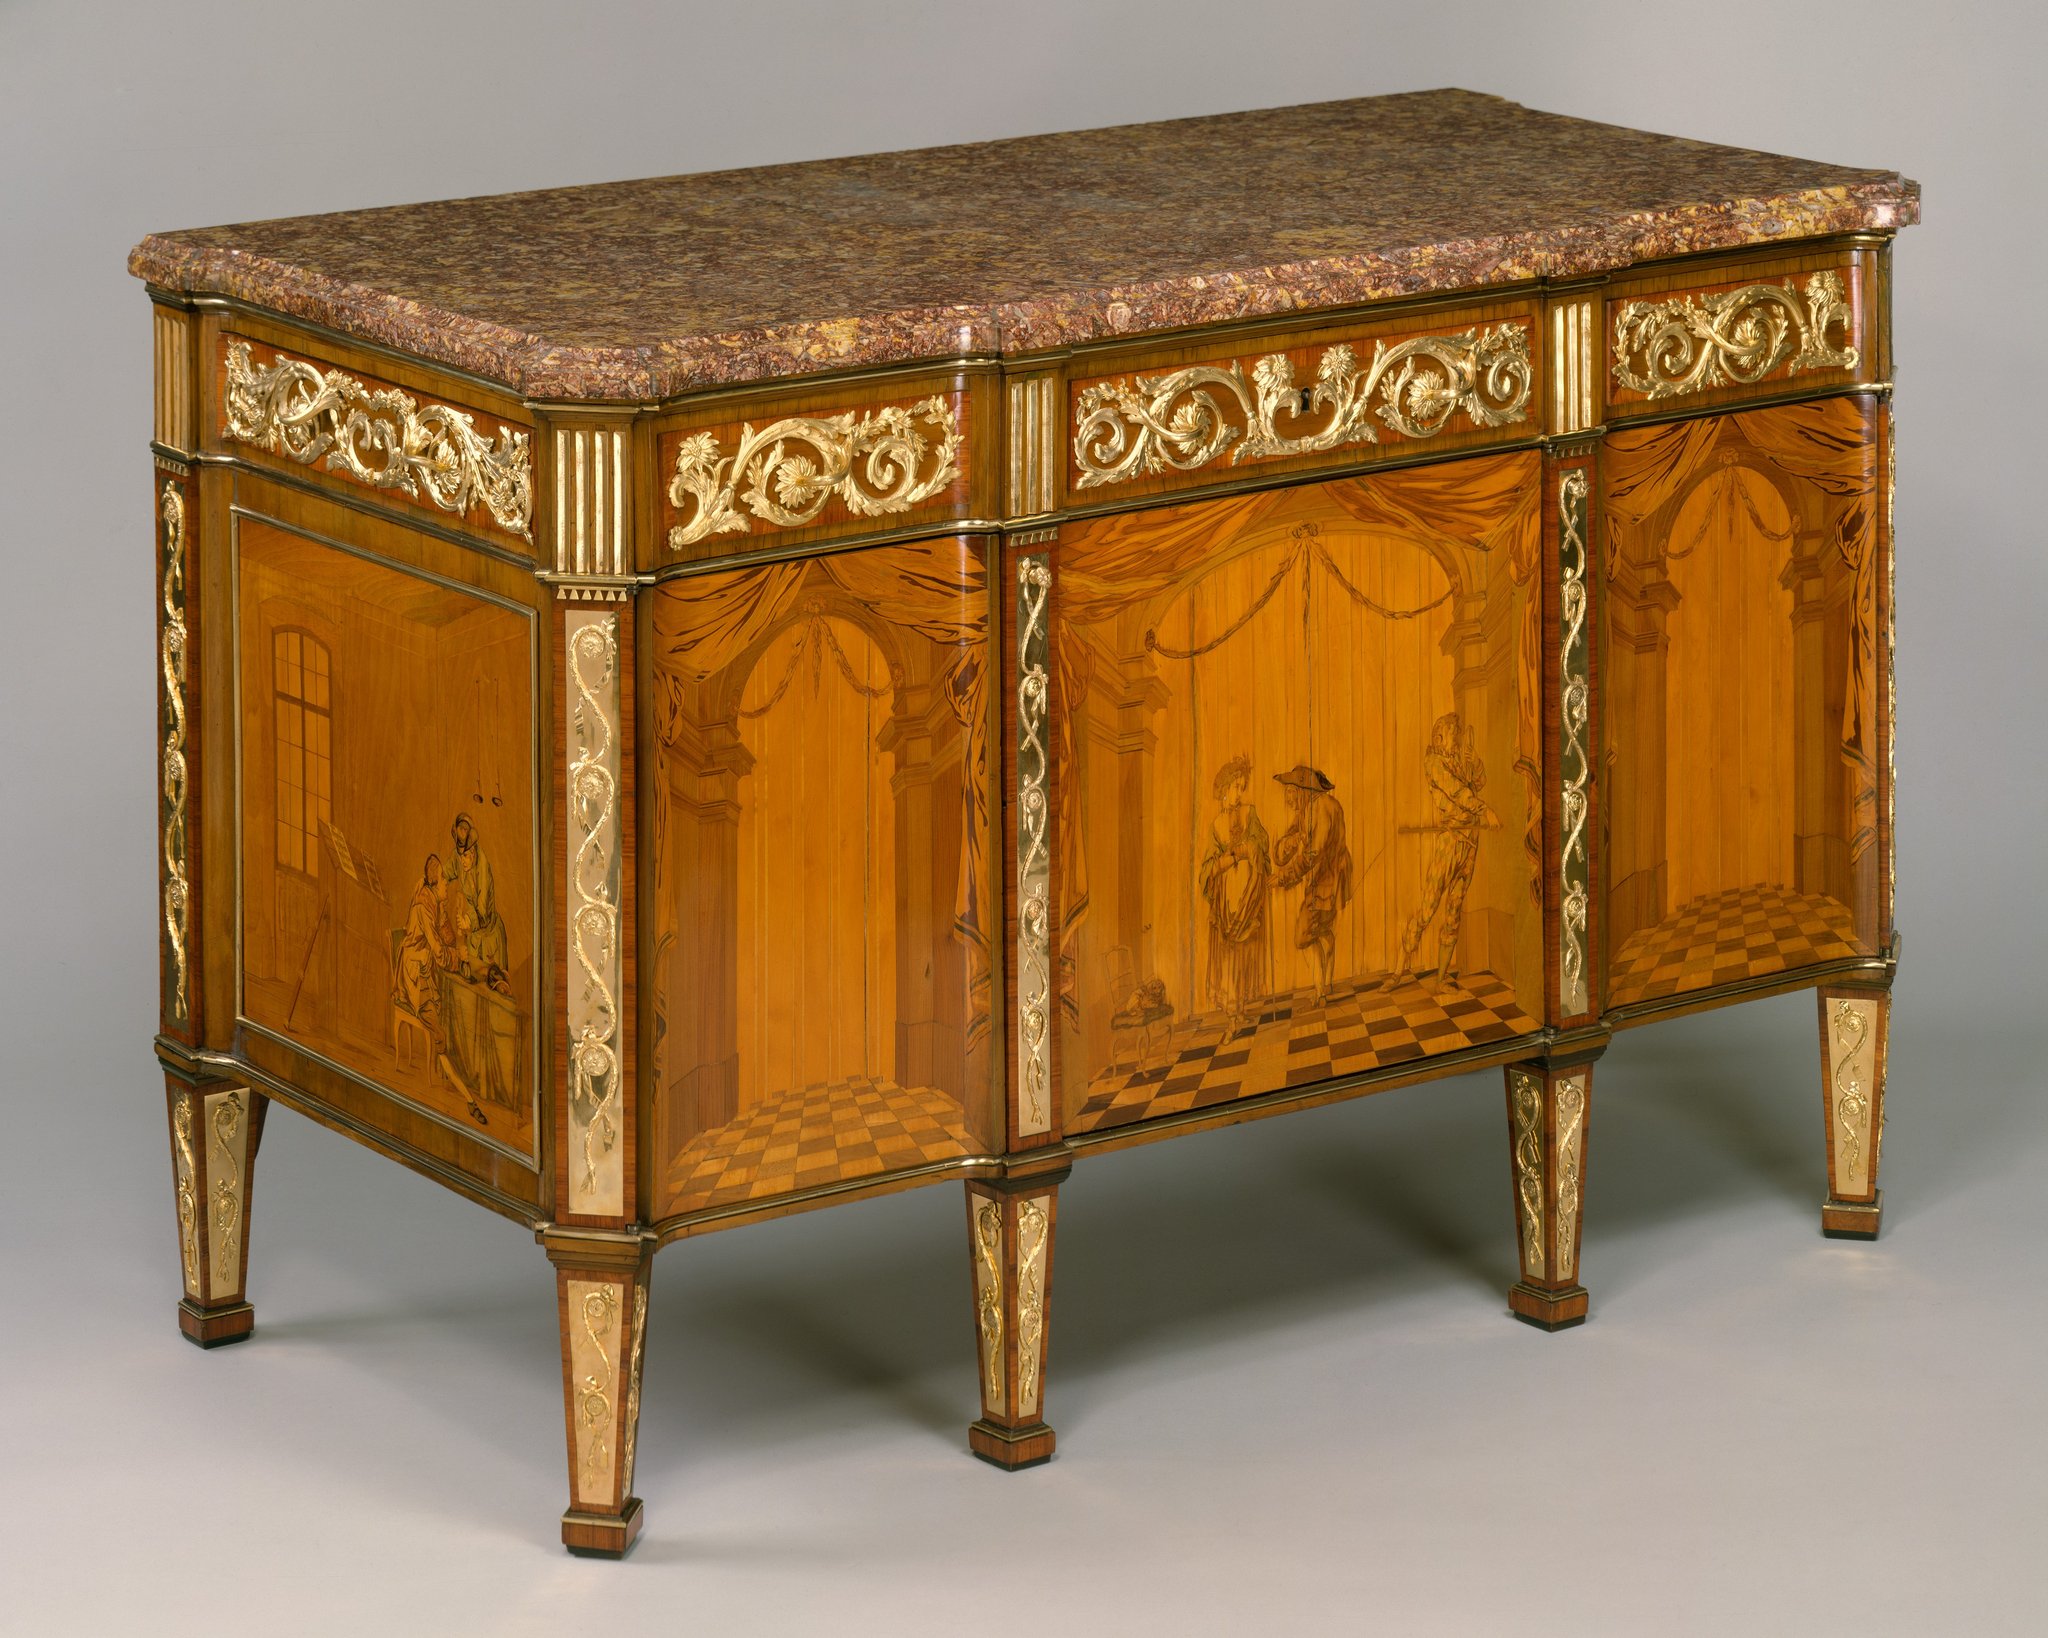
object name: commode à vantaux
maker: david roentgen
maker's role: maker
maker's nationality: german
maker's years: 1743-1807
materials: wood, brass, gilt bronze, iron, marble, steel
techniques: stain, veneering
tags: men,women,dogs